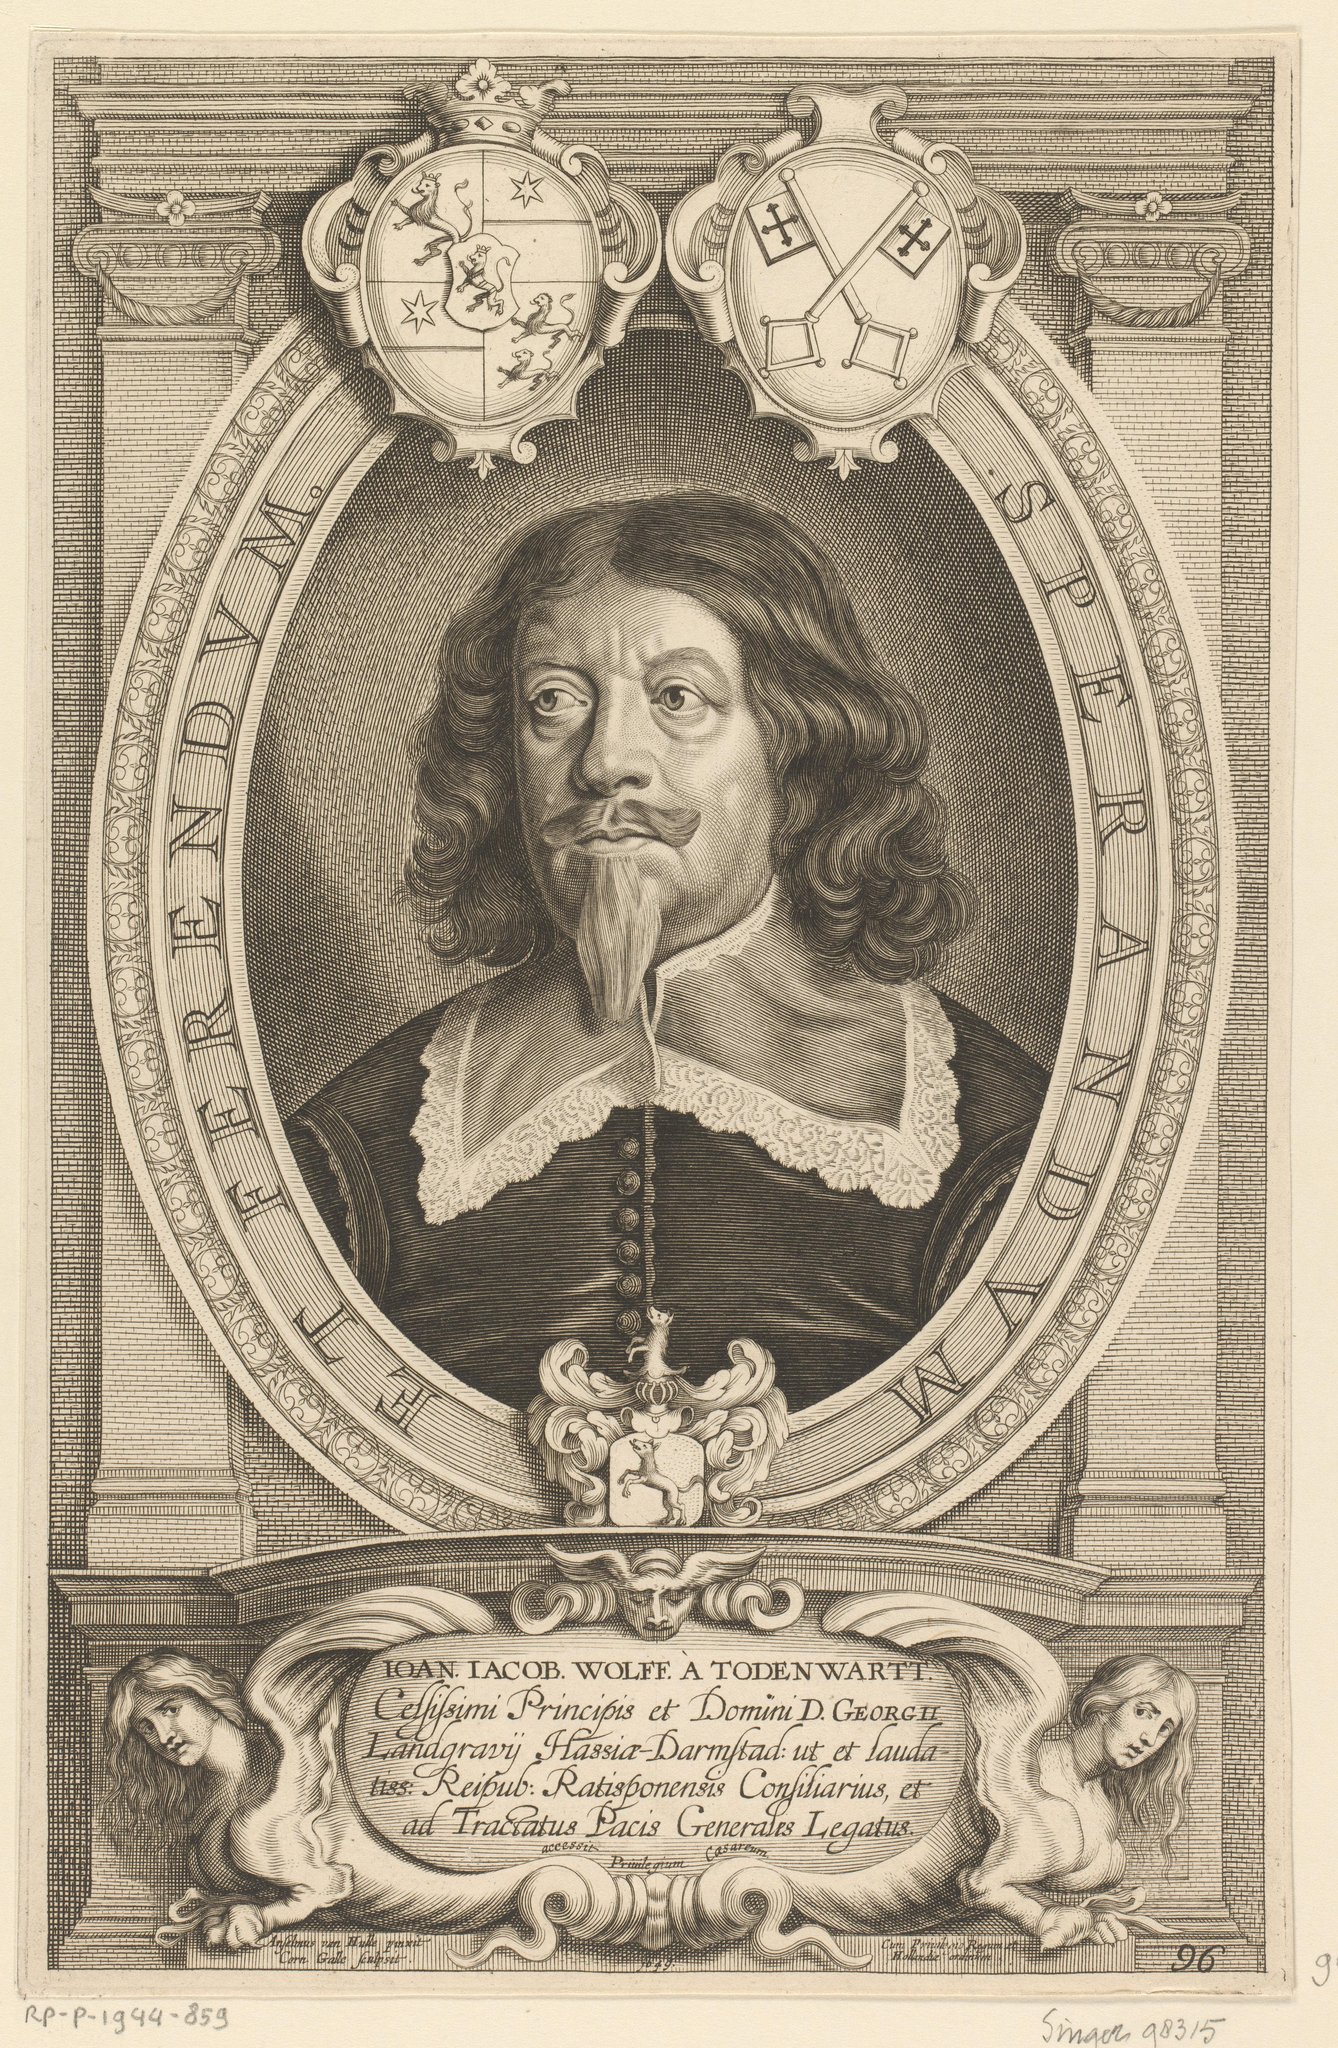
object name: print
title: Ioan. Iacob. Wolff. à Todenwartt. Celsissimi principis et domini D. Georg II (...)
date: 1713-1717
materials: paper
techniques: engraving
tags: historical persons, diplomacy, diplomat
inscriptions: collector's mark: Lugt 2228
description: Prent is gebruikt in verschillende series. De huidige staat is gebruikt in de hieronder vermelde serie en uitgaven (6) en (7). (1)‘Legati Celeberrimi’, uitgegeven door Daniel Middeler in 1648 in Antwerpen. (2)‘Legati Celeberrimi’, waarschijnlijk uitgegeven in 1651, maar opnieuw met de vermelding door Daniel Middeler in 1648 in Antwerpen. (3)‘Legati Celeberrimi', waarschijnlijk uitgegeven in 1658, maar opnieuw met de vermelding door Daniel Middeler in 1648 in Antwerpen. (4) 'Pacificatores orbis Christiani, sive icones principum, ducum et legatorum, qui Monasterii atque Osnabrugae (...)', uitgegeven door Pieter van der Slaart in 1696 in Rotterdam. (5) 'Pacificatores orbis Christiani, sive icones principum, ducum et legatorum, qui Monasterii atque Osnabrugae (...)', uitgegeven door Pieter van der Slaart in 1697 in Rotterdam. (6) 'Pacificatores orbis Christiani, sive icones principum, ducum et legatorum, qui Monasterii atque Osnabrugae (...)', waarschijnlijk uitgegeven circa 1713, maar opnieuw met vermelding van Pieter van der Slaart in 1697 in Rotterdam. De platen in deze uitgave zijn voor het eerst genummerd. (7) 'Les hommes illustres qui ont vécu dans le XXIIe siècle (...)', uitgegeven door David Mortier in 1717 in Rotterdam. Zie documentatie. Mogelijk zijn er nog meerdere uitgaven en staten van deze prent.